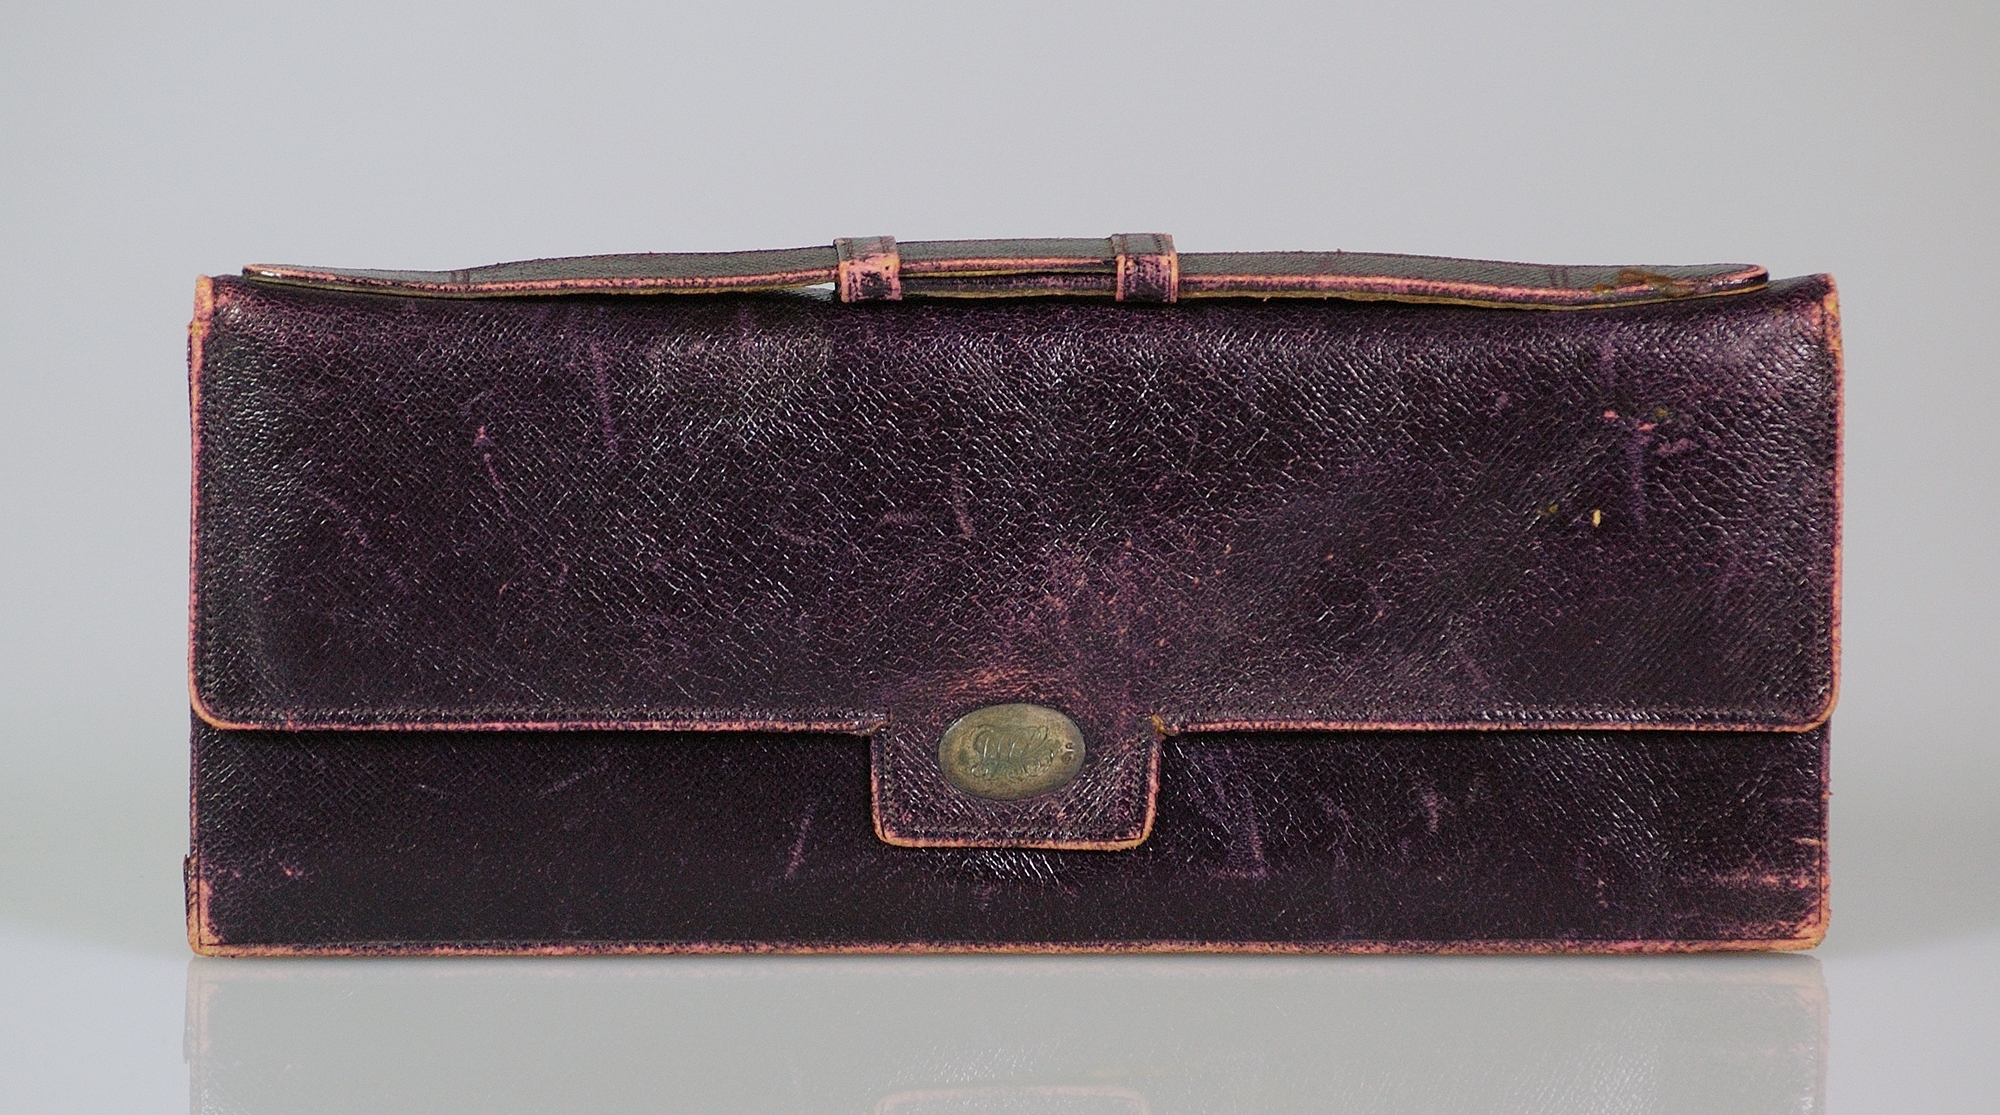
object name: bag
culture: austrian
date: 1870-1880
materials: leather, metal, silk